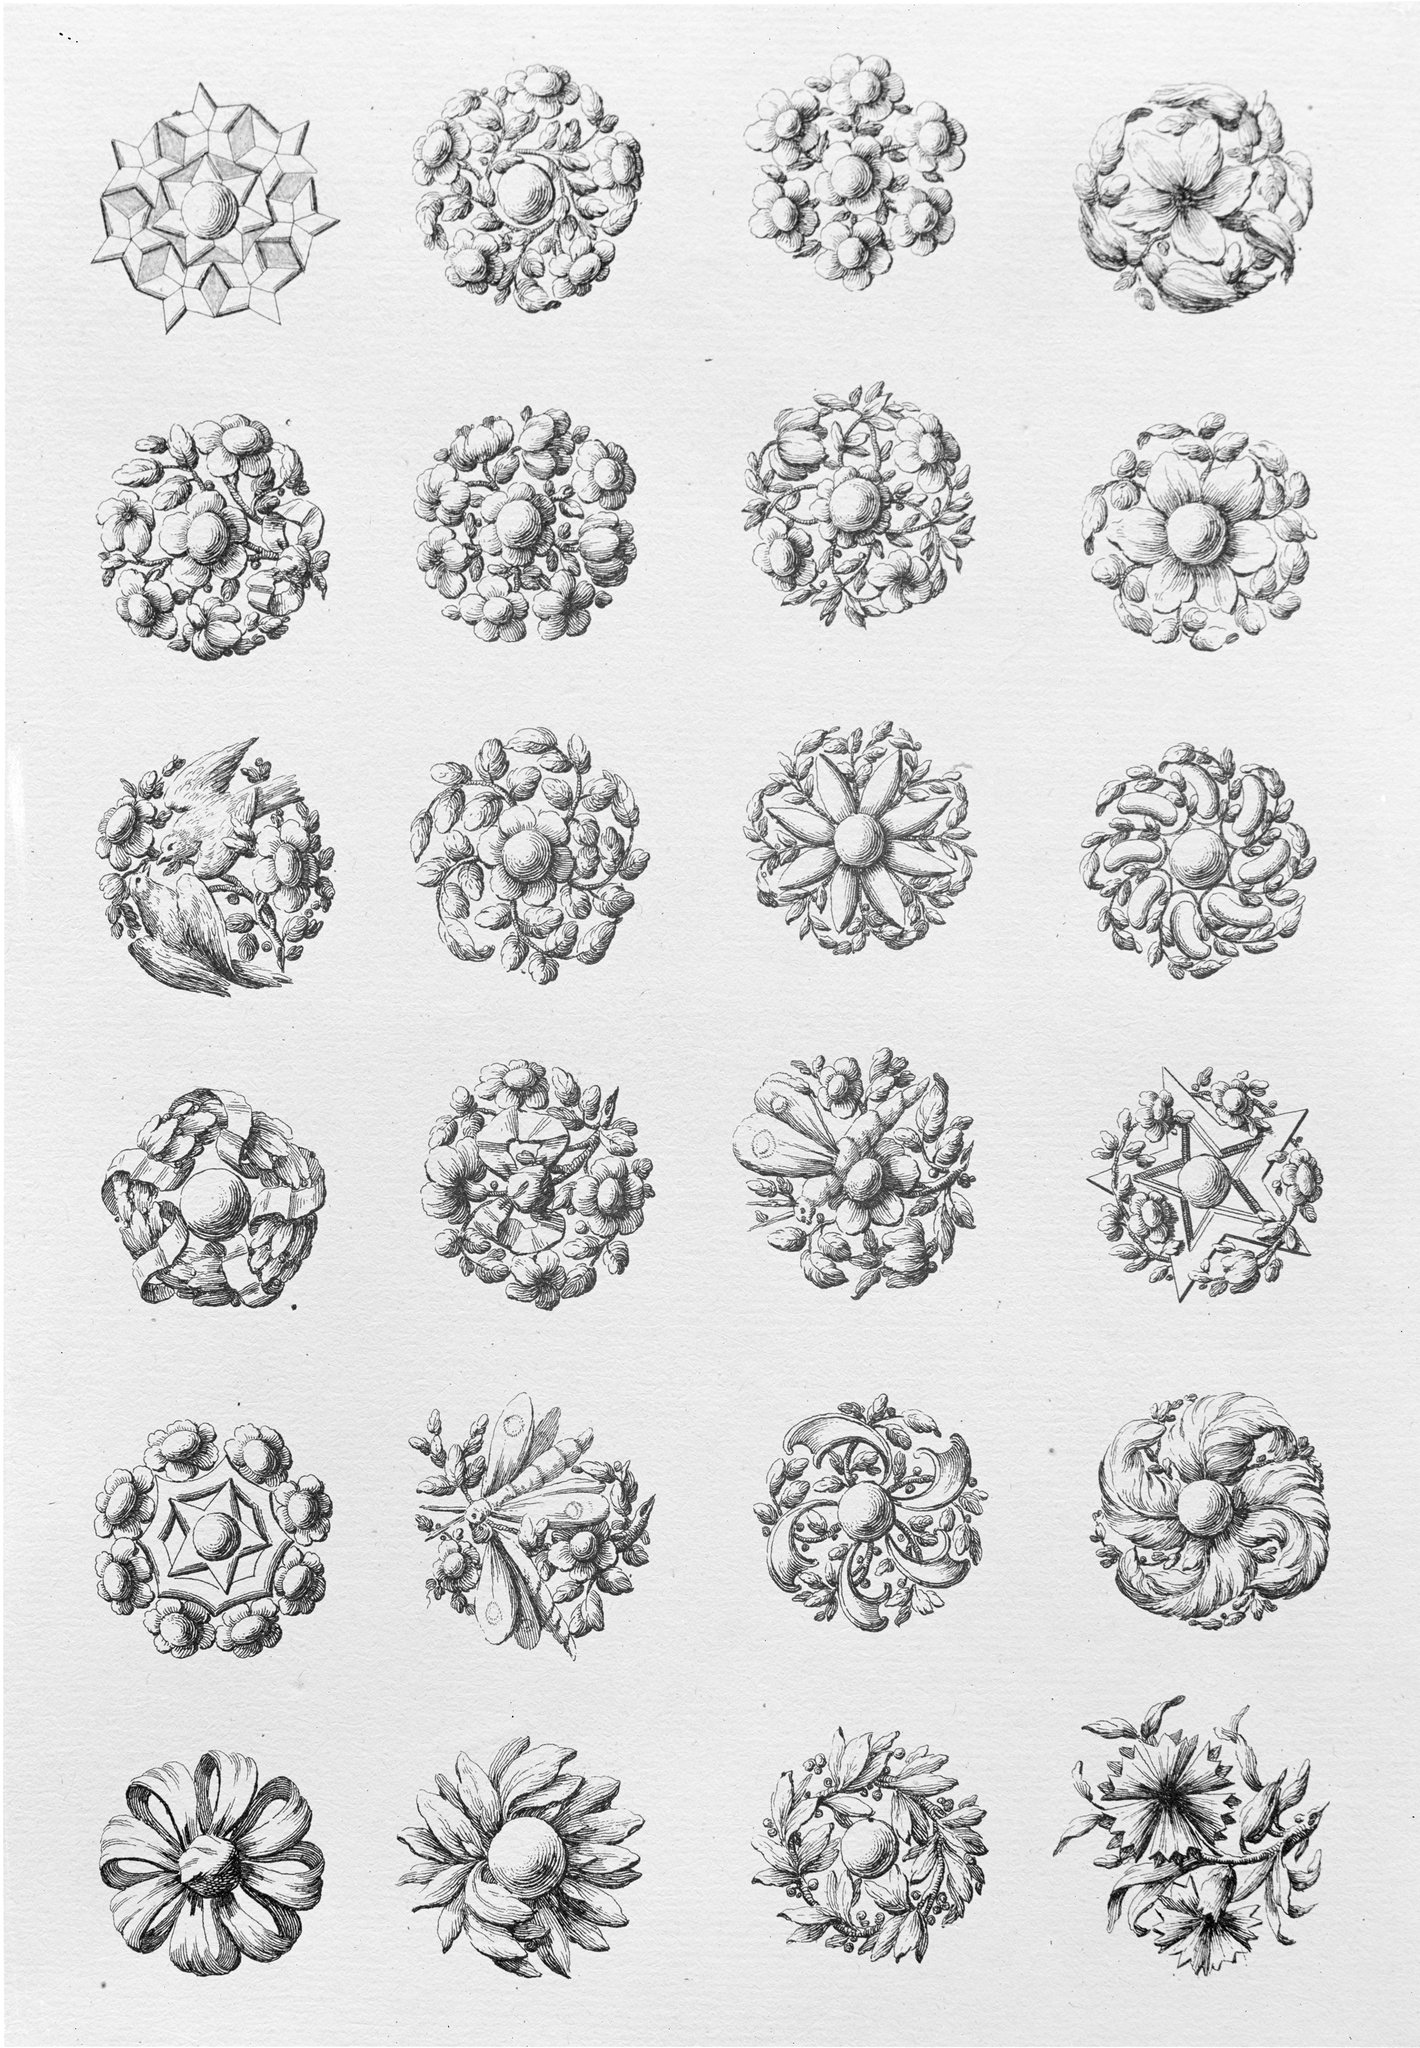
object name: book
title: Livre de Desseins De Jouaillerie Et Bijouterie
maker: maria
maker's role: artist and publisher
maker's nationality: french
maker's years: 1700-1800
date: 1740-1775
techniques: engraving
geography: france